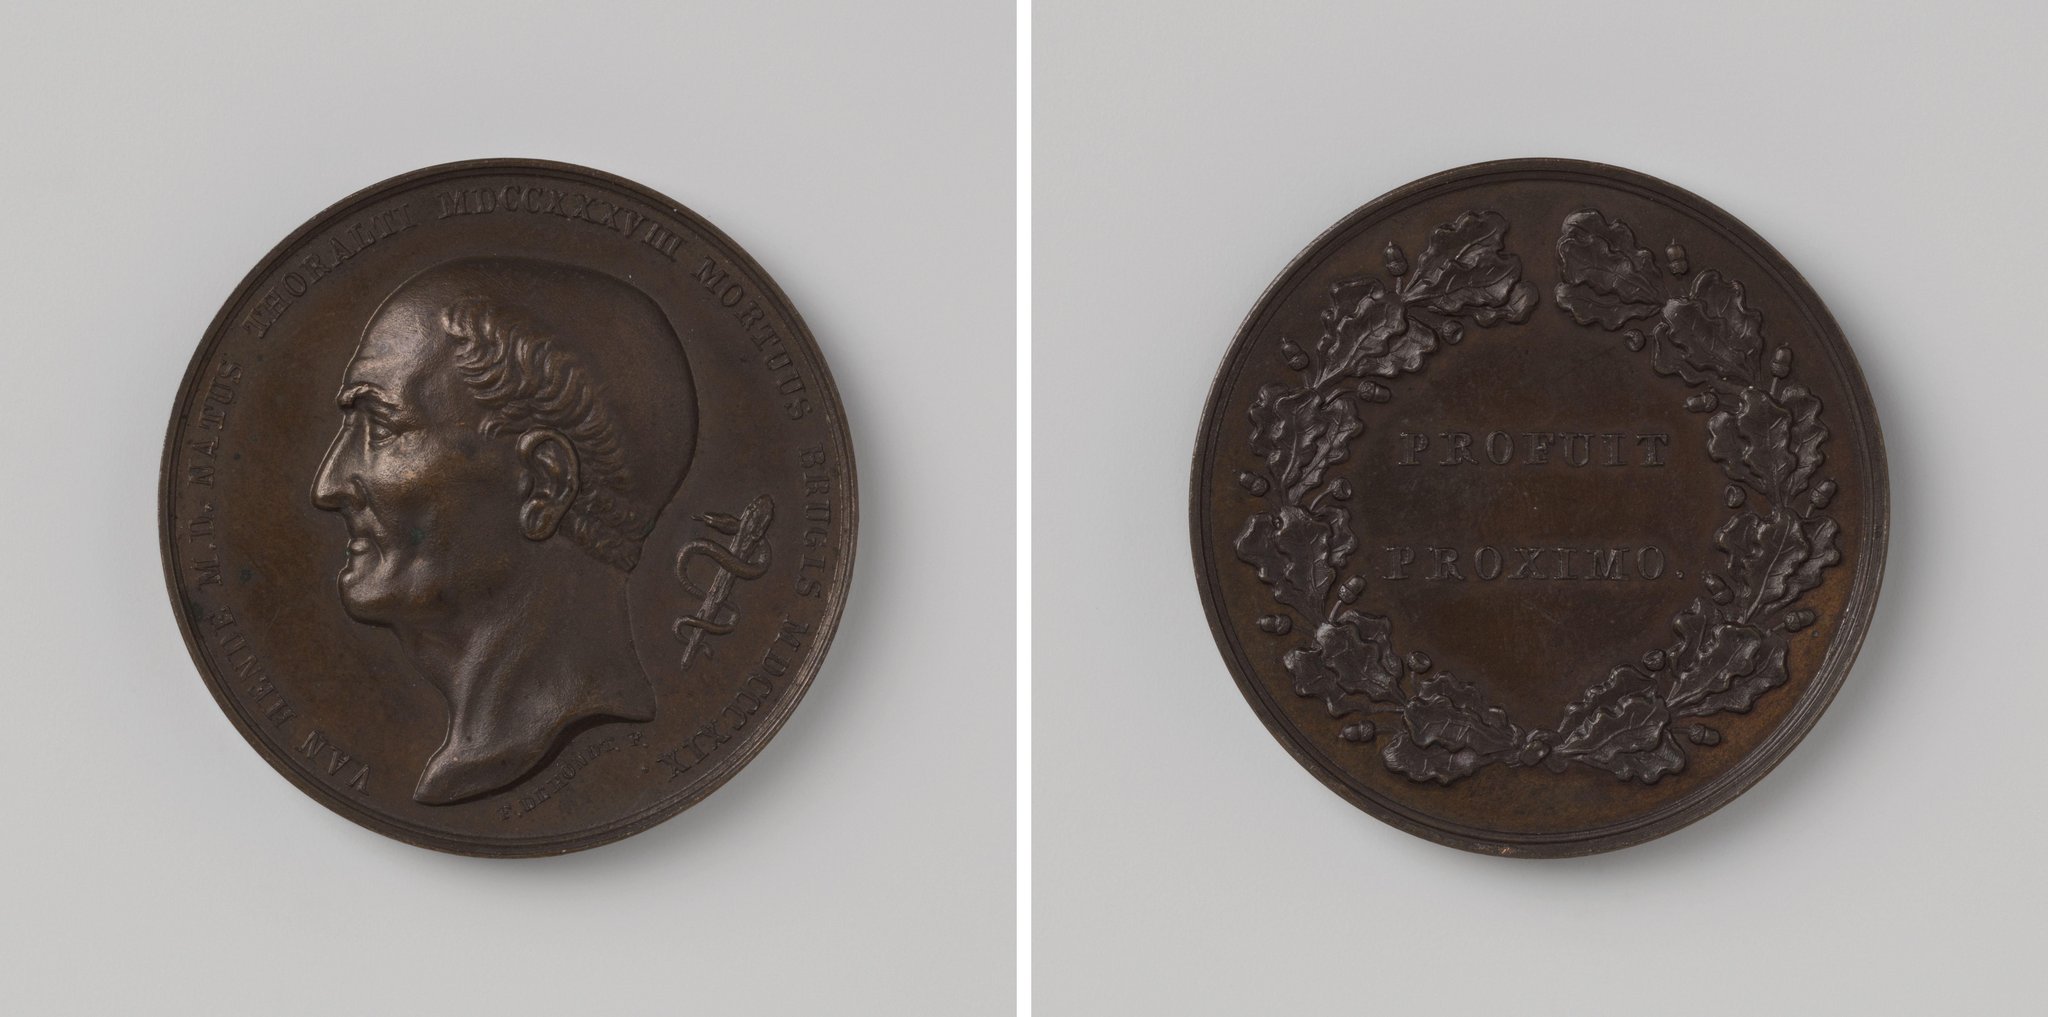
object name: history medal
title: Overlijden van J.F.L. van Hende, dokter te Brugge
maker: franciscus johannes de hondt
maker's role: print maker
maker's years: 1786-1862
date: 1822-1823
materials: bronze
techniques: striking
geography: bruges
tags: j.f.l. van de hende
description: Bronzen penning. Voorzijde: borststuk man; rechts slang gekronkeld om knots binnen omschrift. Keerzijde: opschrift binnen eikekrans